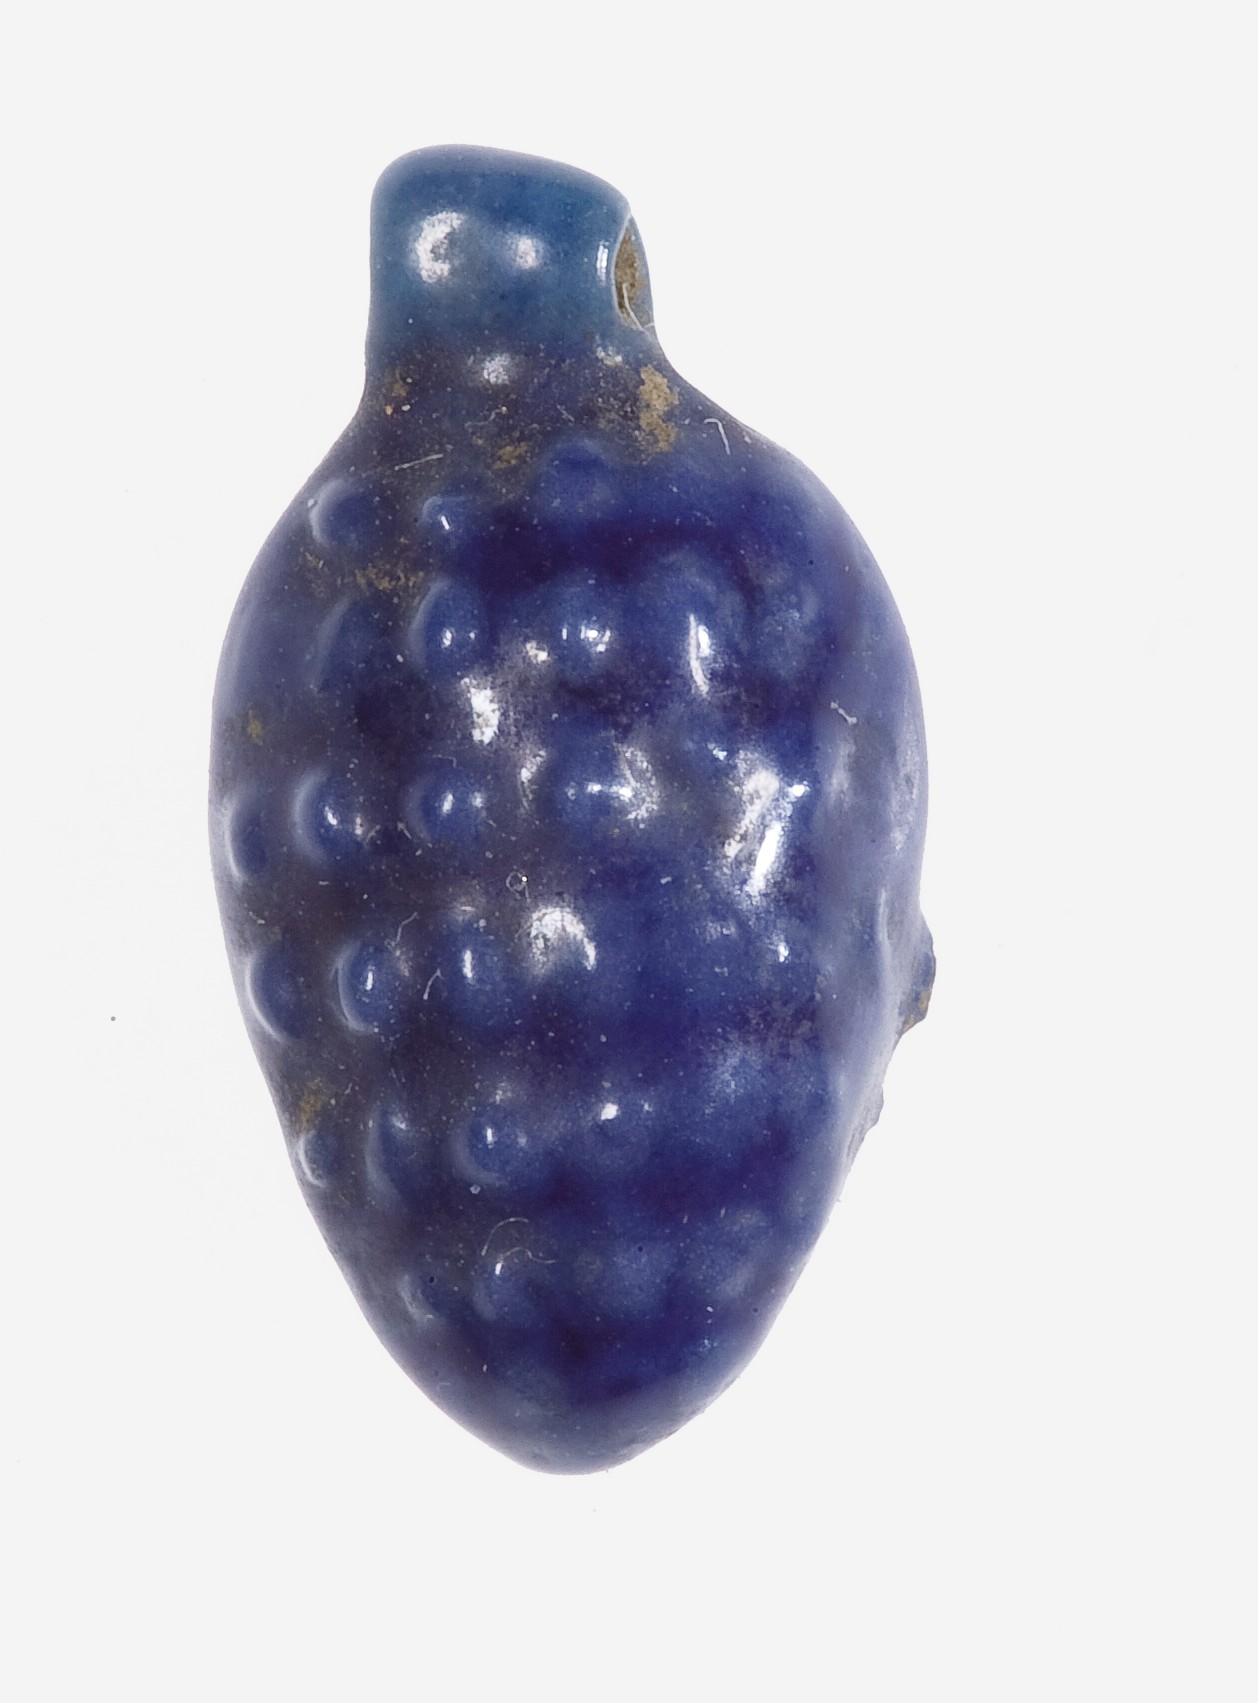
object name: pendant, grape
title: Pendant: Bunch of Grapes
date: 1390-1352 BCE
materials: faience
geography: egypt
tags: grapes